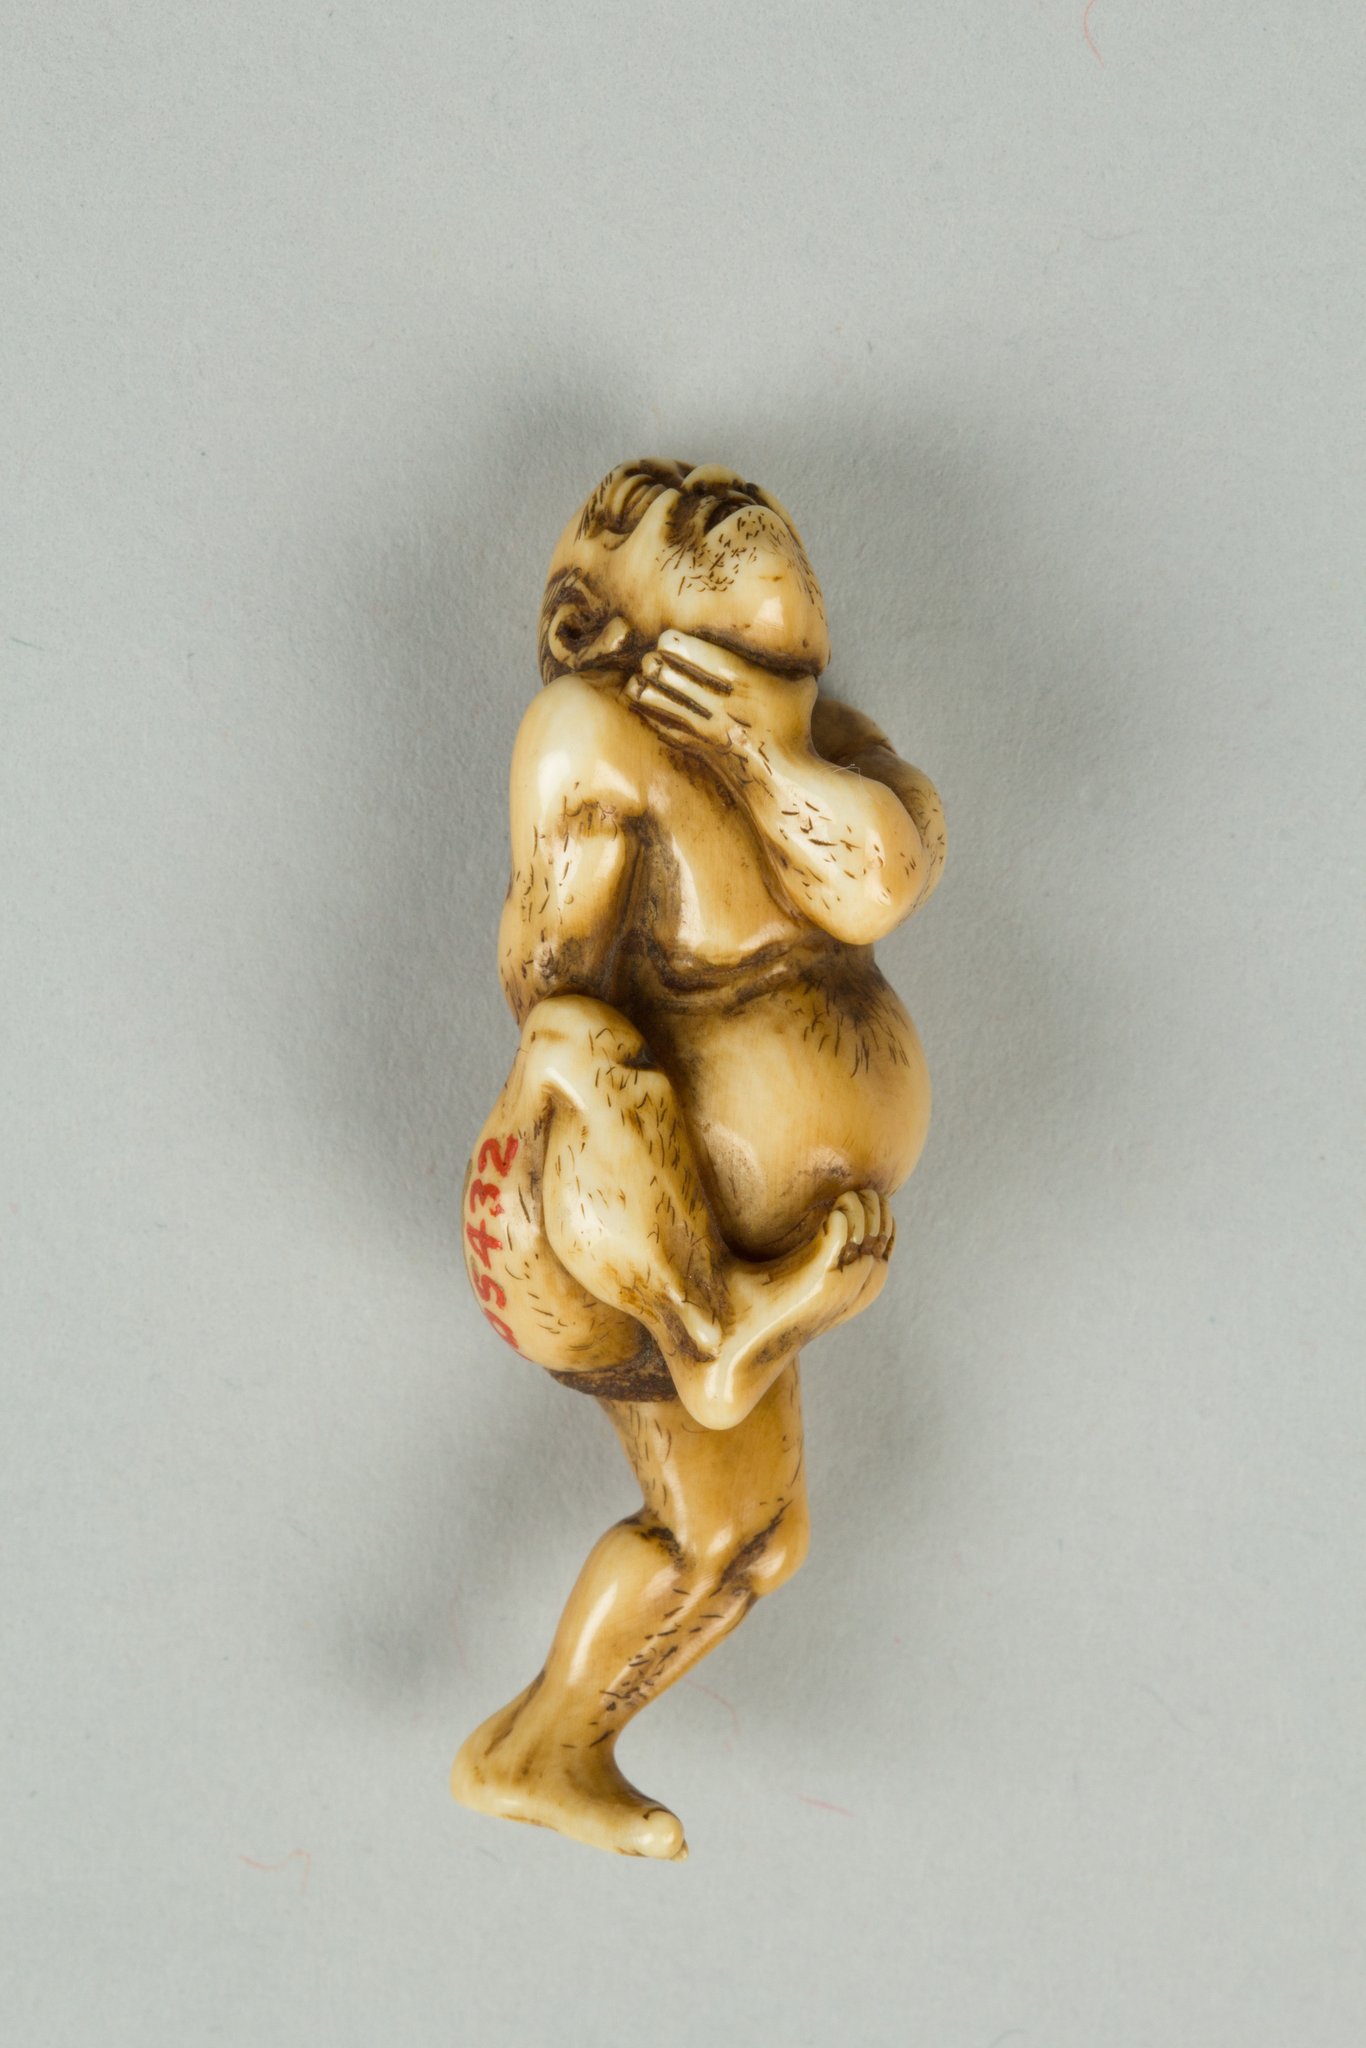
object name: netsuke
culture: japanese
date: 1801-1900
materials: ivory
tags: men